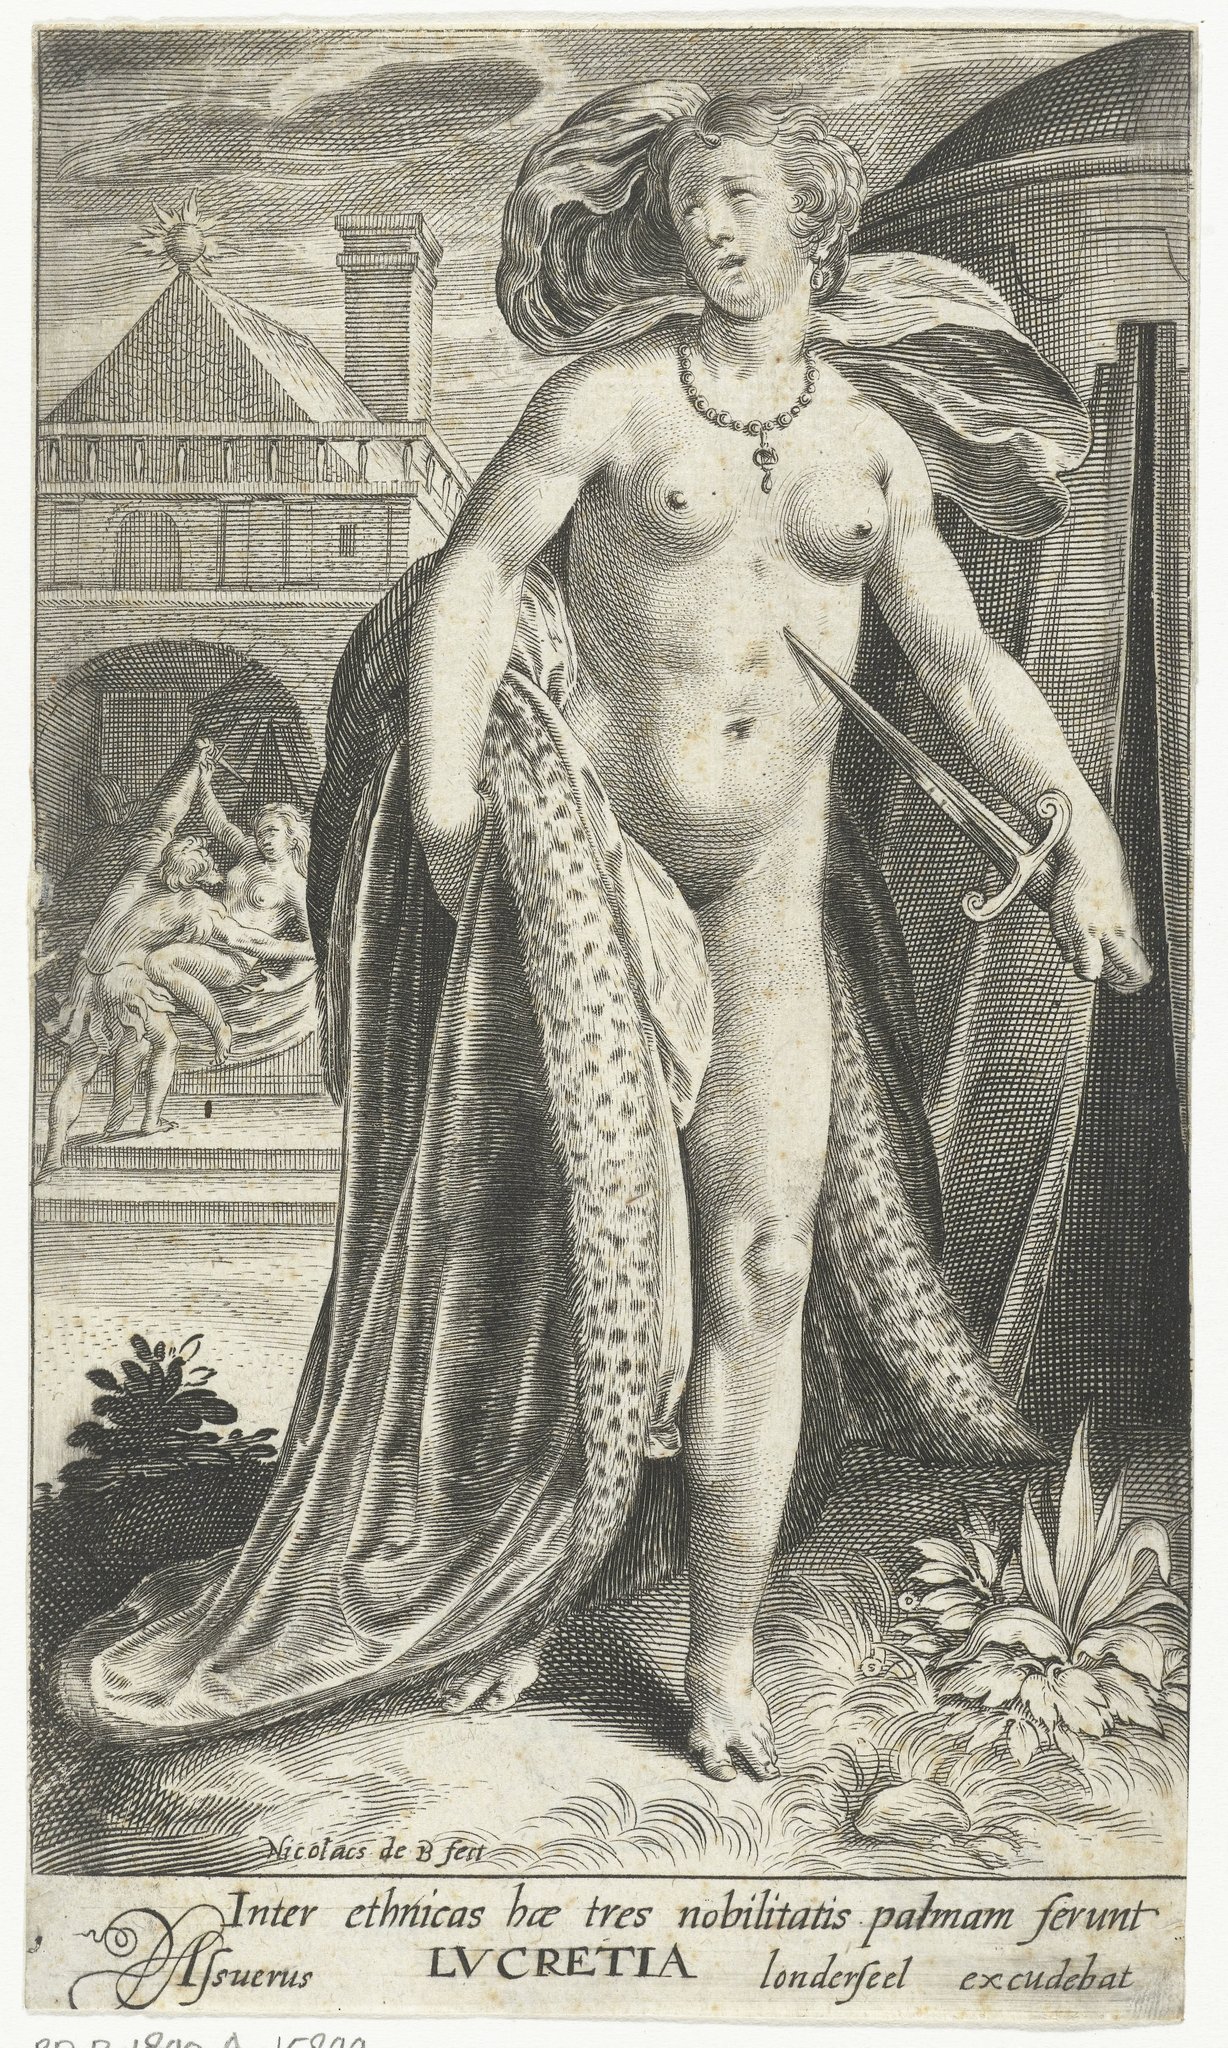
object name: print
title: Lucretia met dolk tegen haar borst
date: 1581-1656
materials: paper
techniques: engraving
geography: netherlands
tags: death of lucretia: she commits suicide by stabbing herself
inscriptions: collector's mark: Lugt 2228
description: Lucretia staat met een dolk op haar borst gericht om zichzelf te doden.